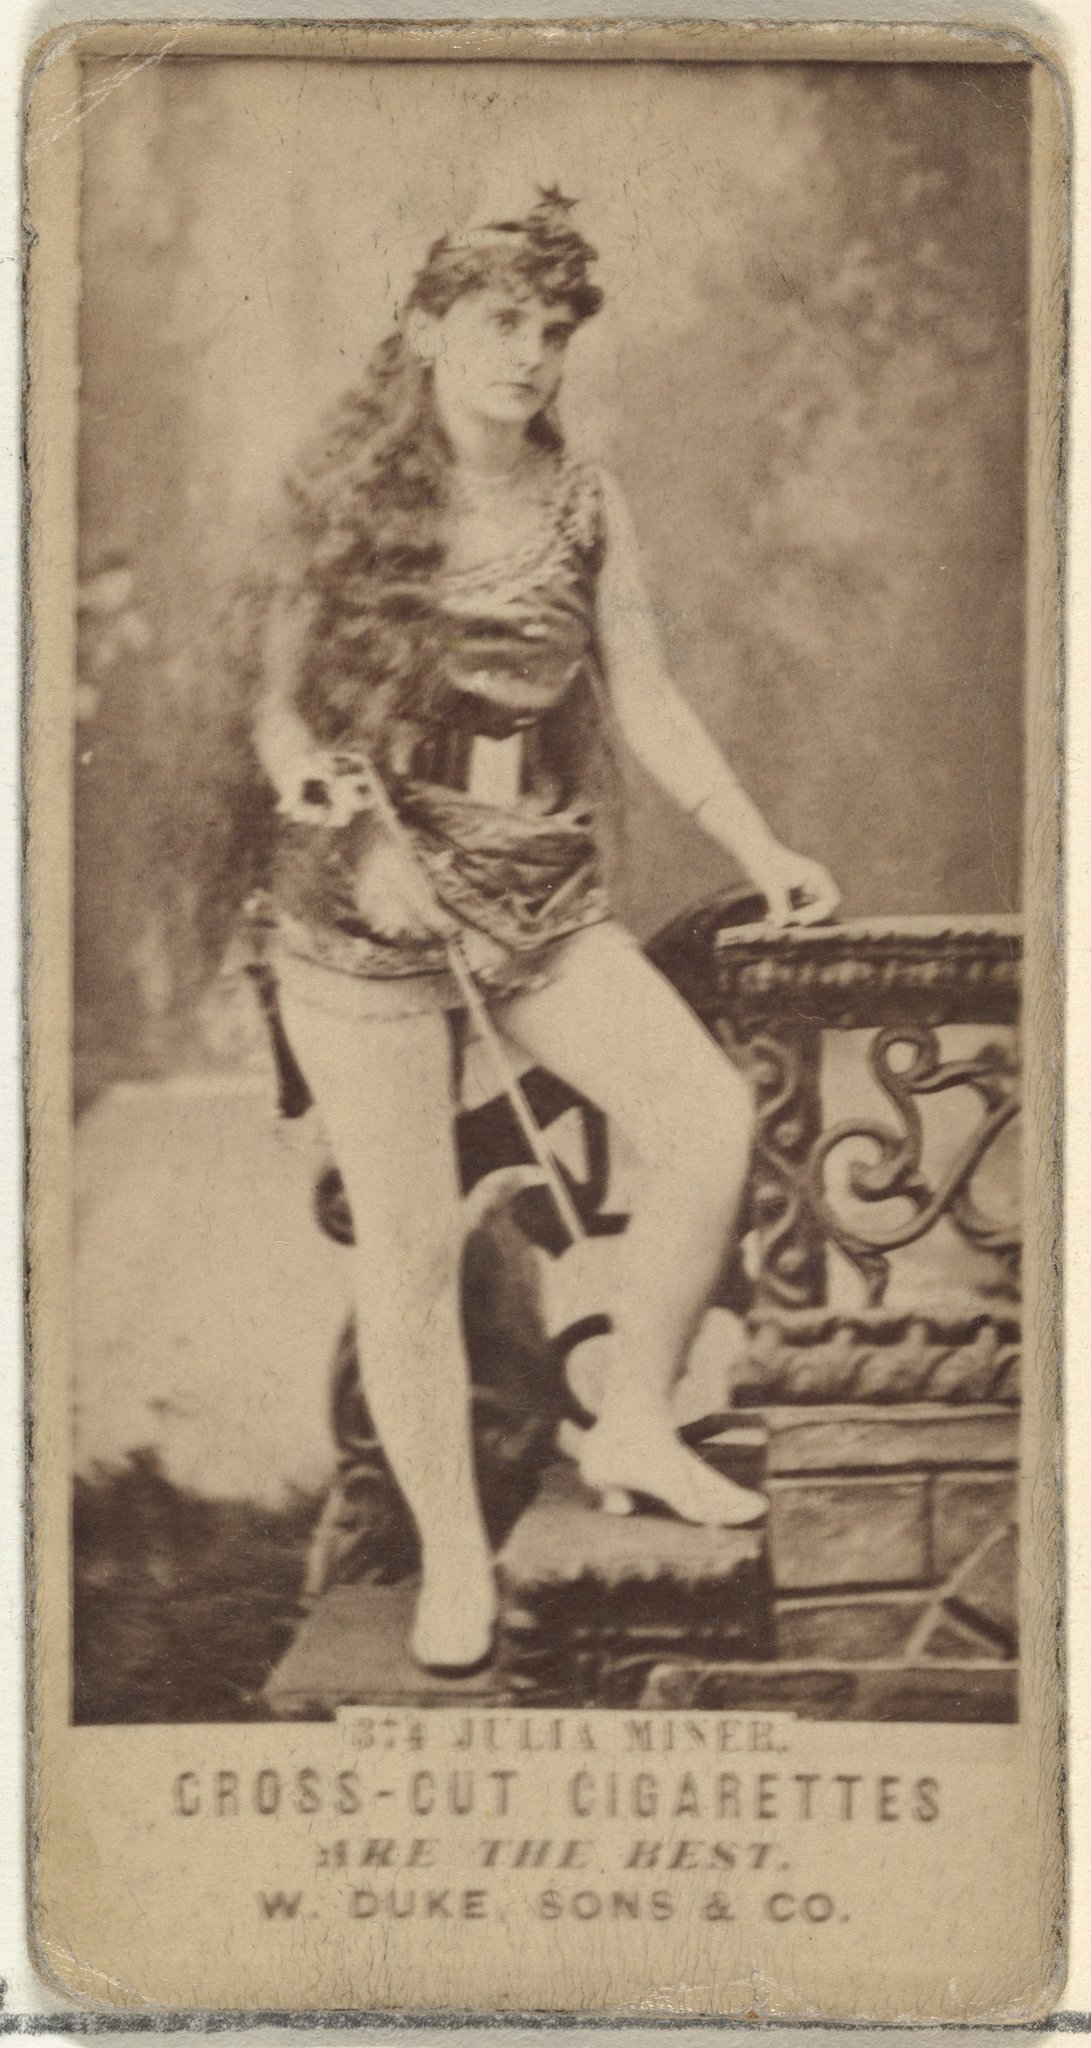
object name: photograph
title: Card Number 374, Julia Miner, from the Actors and Actresses series (N145-3) issued by Duke Sons & Co. to promote Cross Cut Cigarettes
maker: w. duke, sons & co.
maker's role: publisher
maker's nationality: american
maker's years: 1870-1920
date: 1880-1889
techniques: albumen silver print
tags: portraits,women,actresses